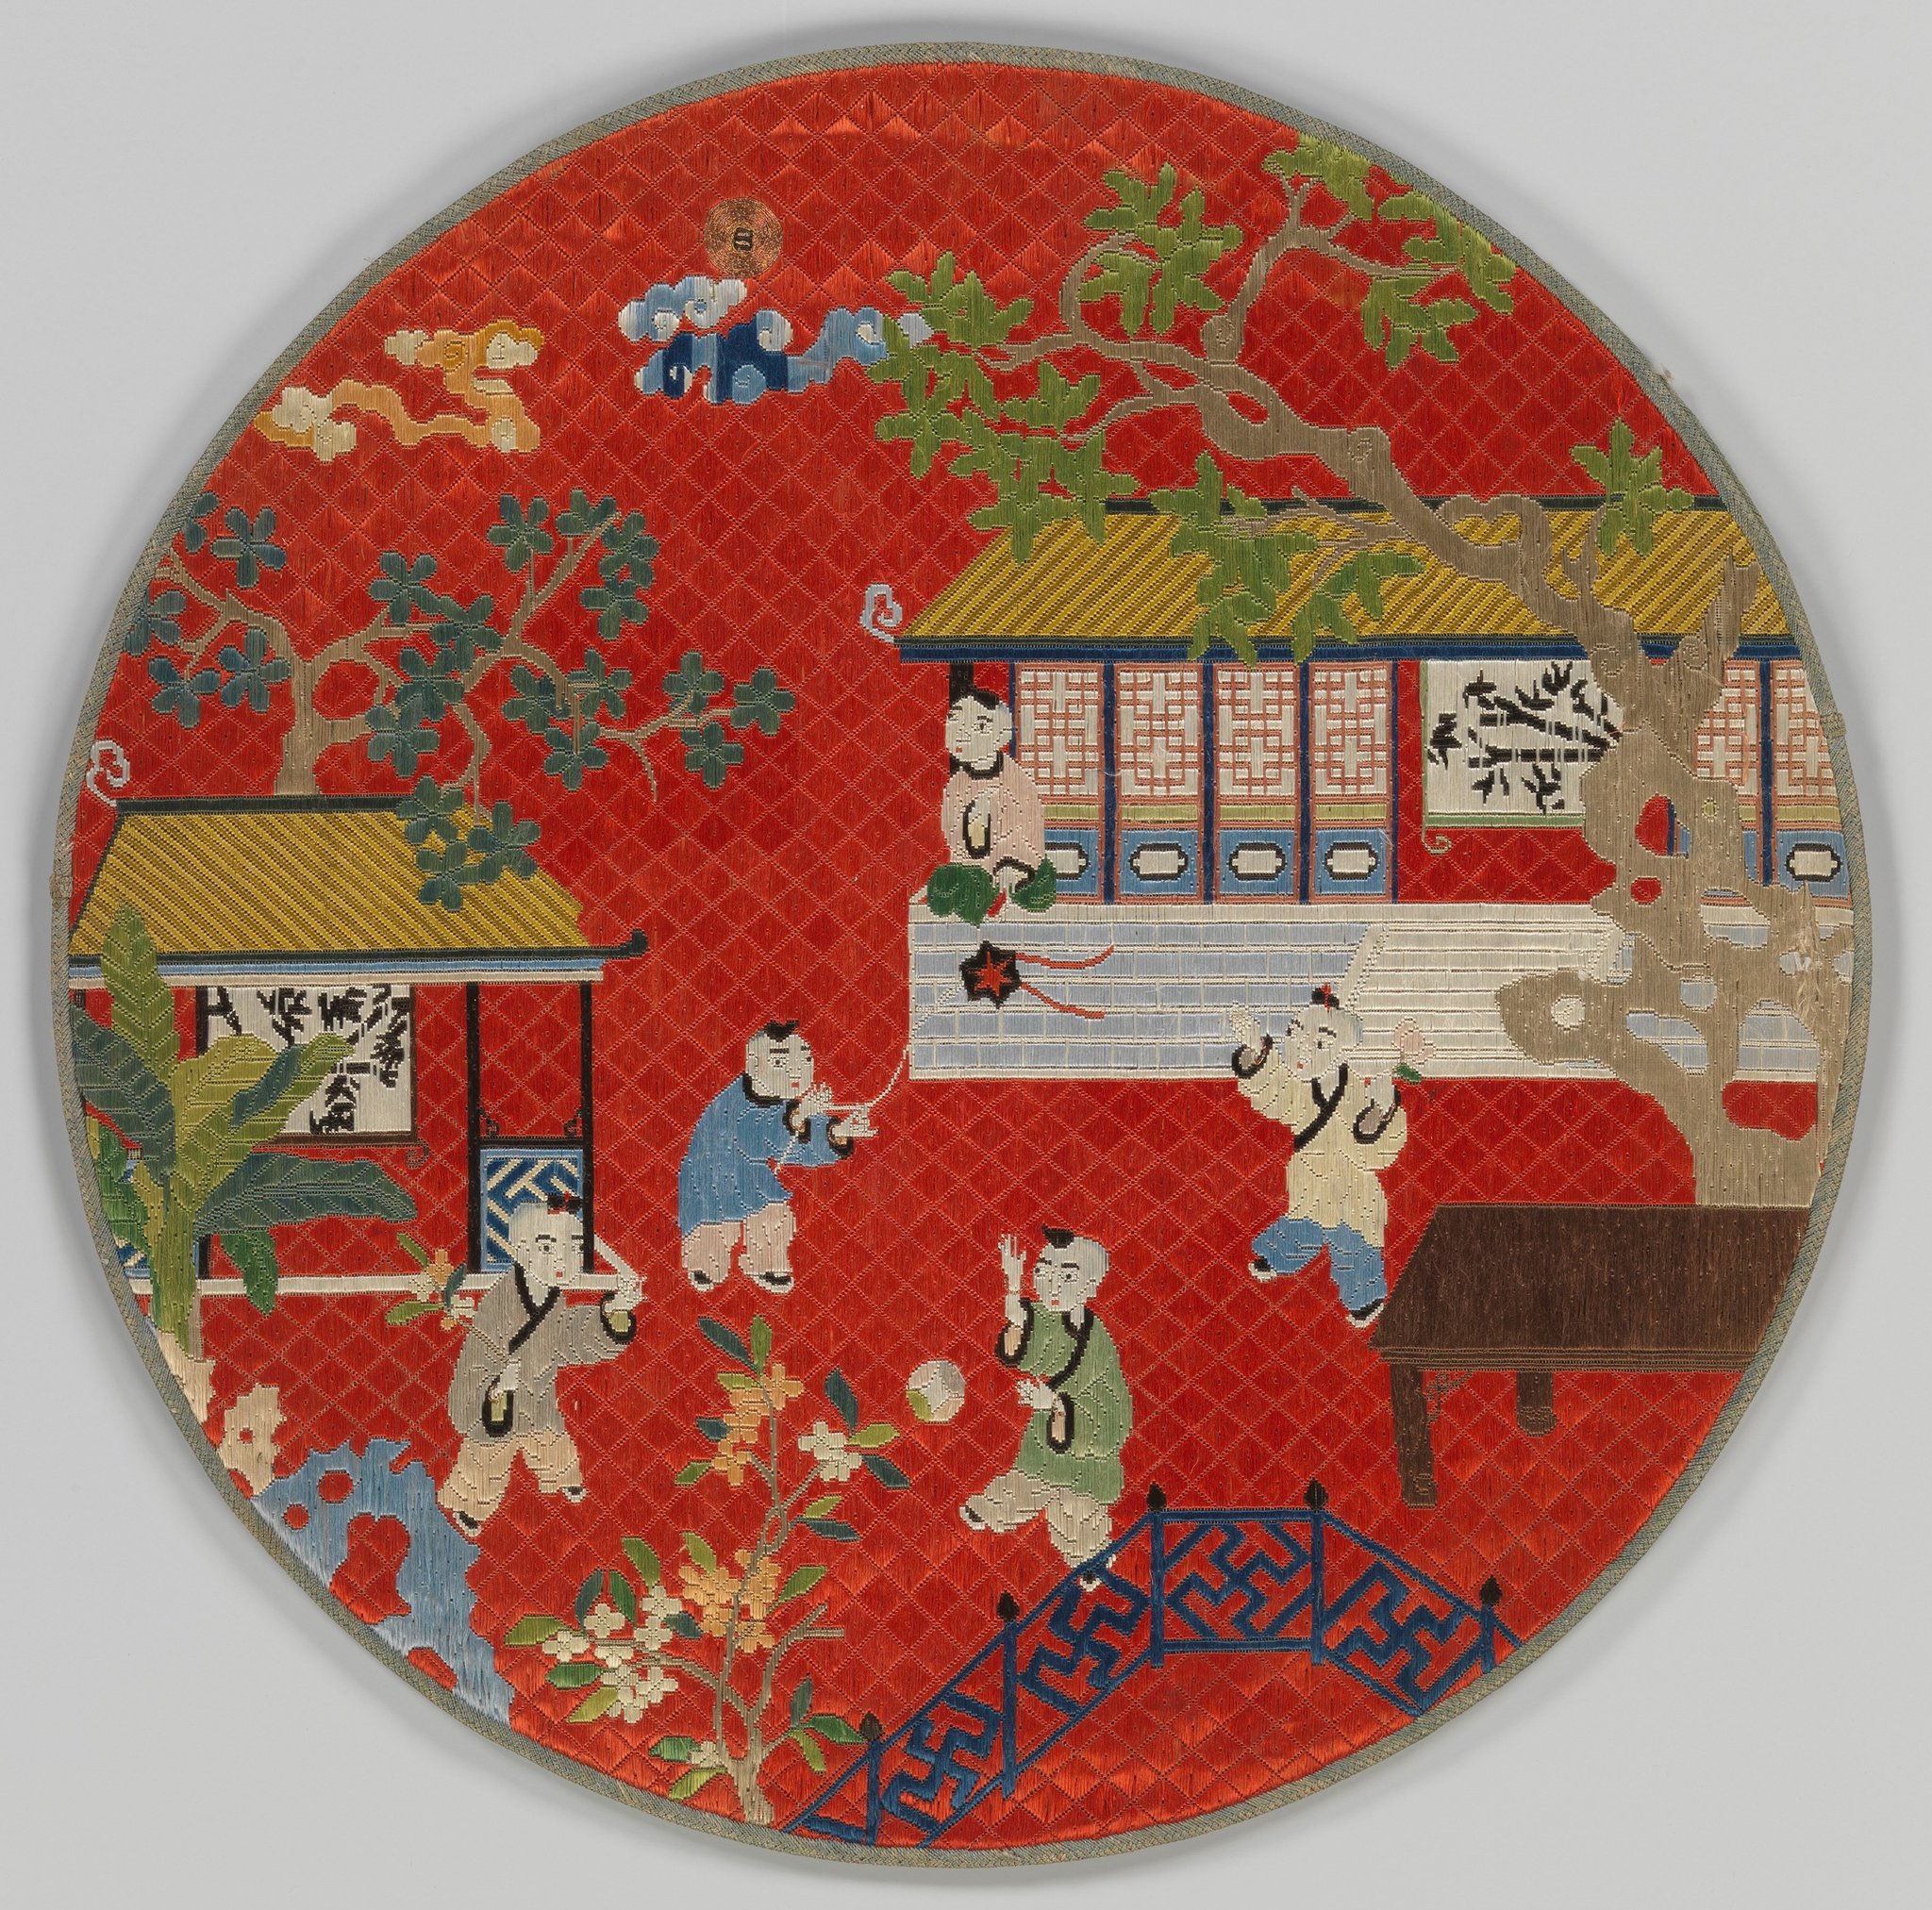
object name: mirror case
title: Mirror case with boys at play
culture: chinese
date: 1801-1900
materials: textile, metal thread, silk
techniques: embroidery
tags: houses,boys,playing